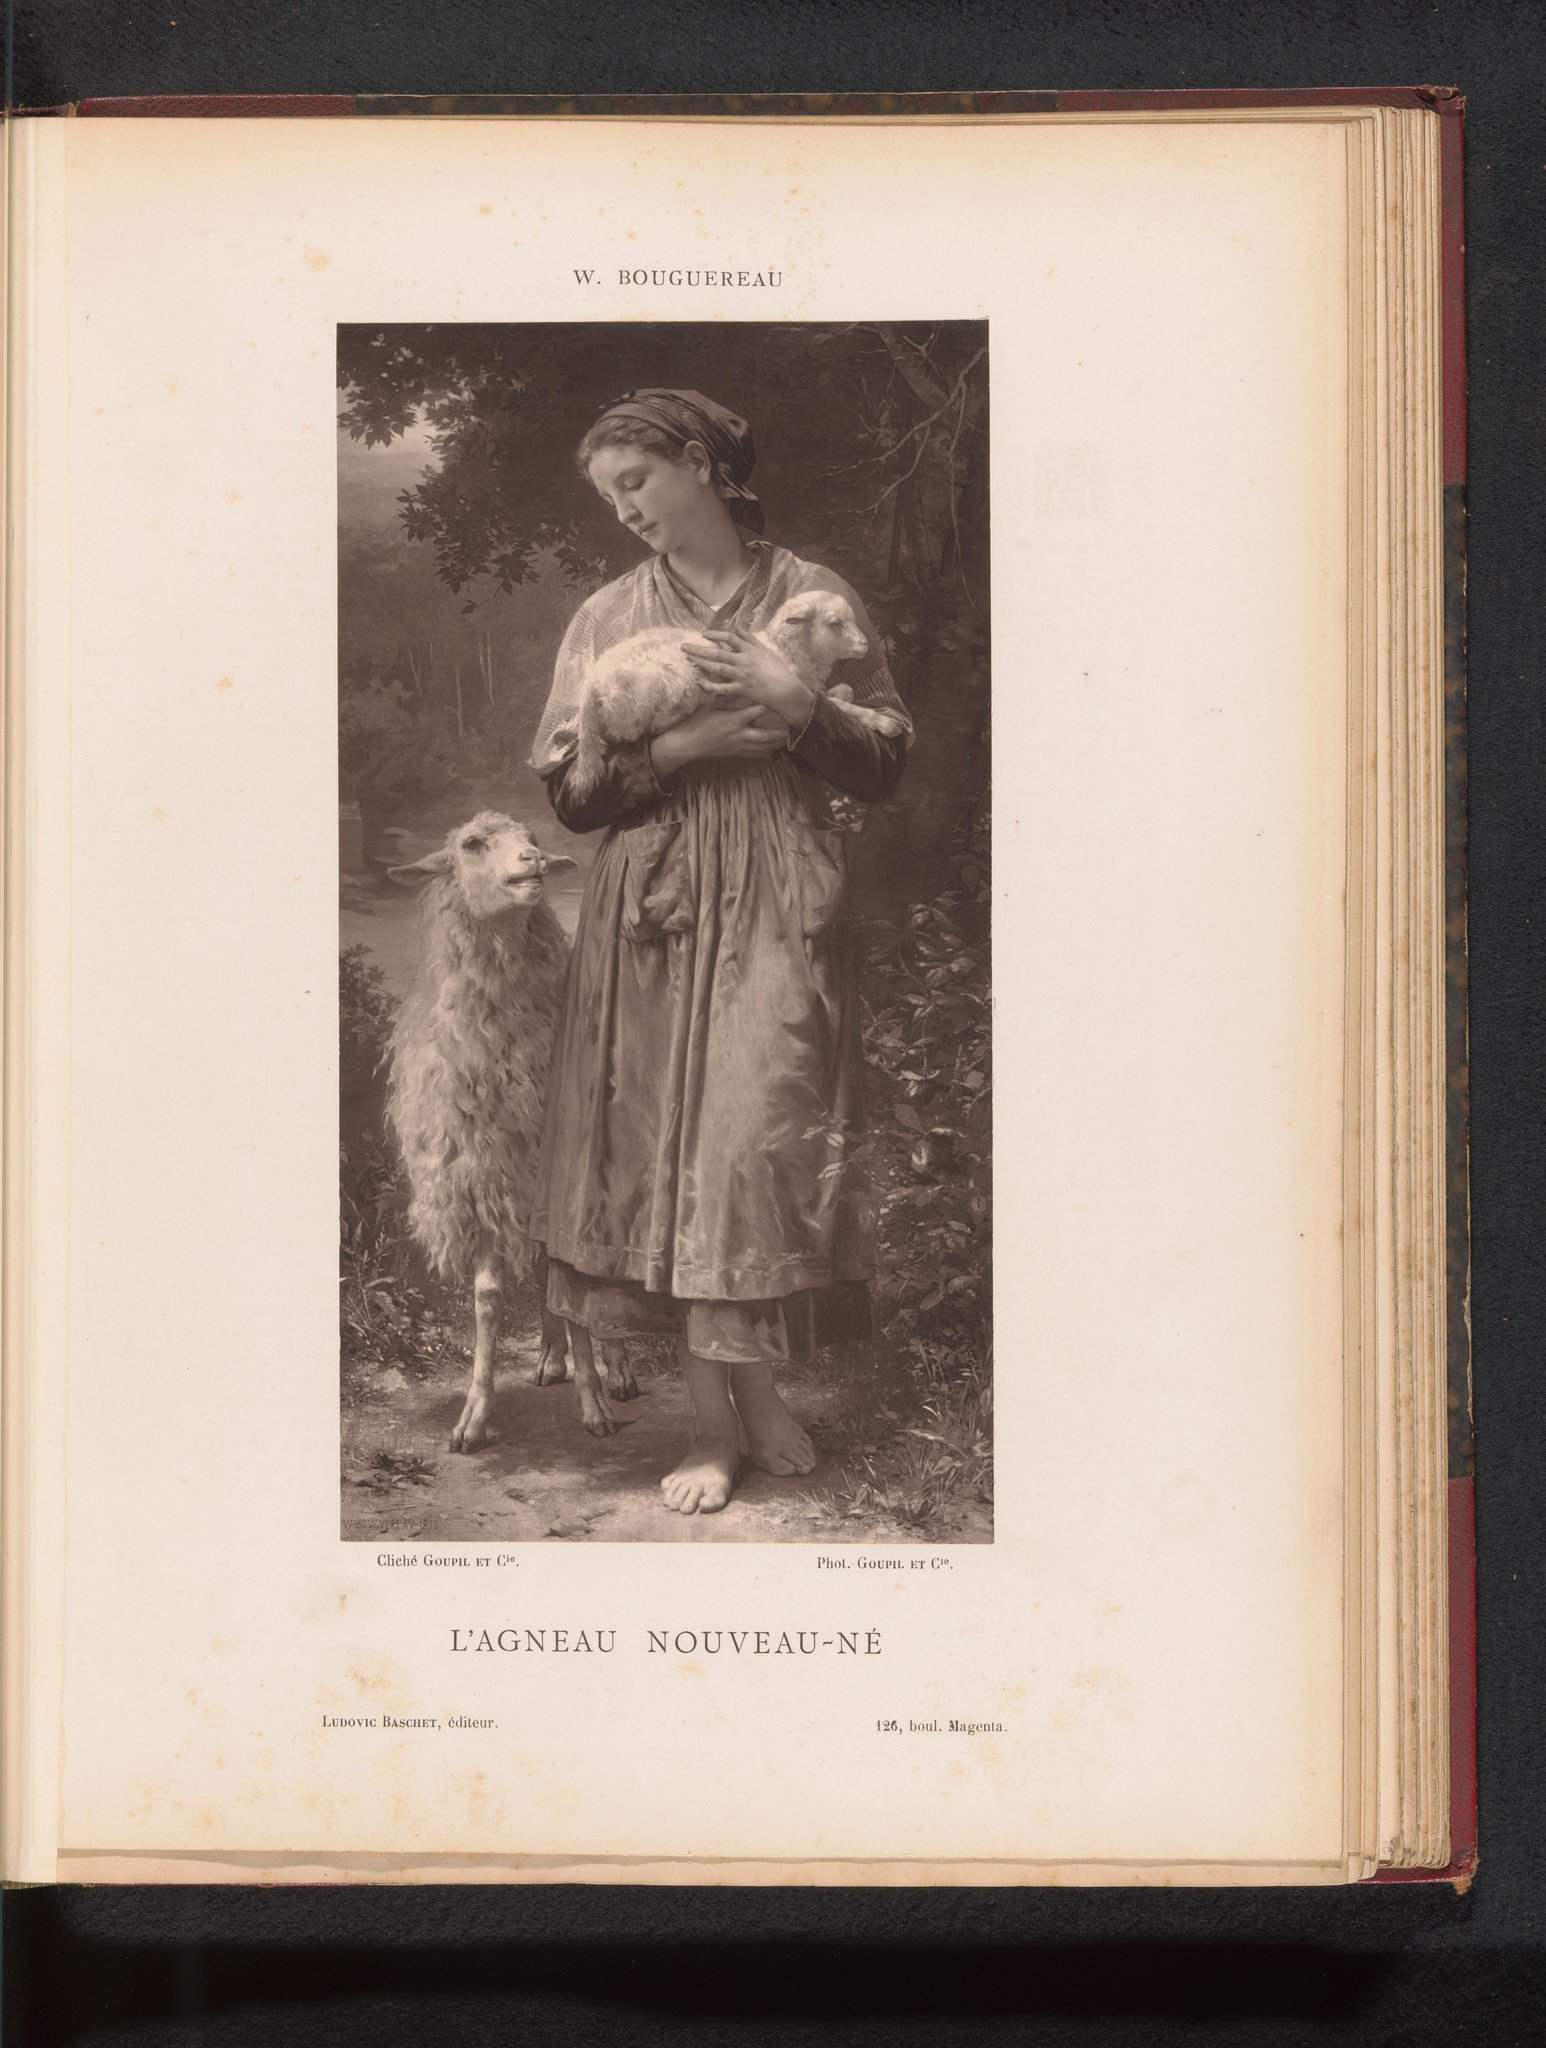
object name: page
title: L'agneau nouveau-né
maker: william-adolphe bouguereau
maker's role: draughtsman, painter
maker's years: 1825-1905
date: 1871-1876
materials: paper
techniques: woodburytype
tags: painter, draughtsman, adolescent, young woman, maiden, lamb, painting, drawing and the graphic arts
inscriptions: inscription: ‘Galerie Contemporaine/ Ludovic Baschet, éditeur.’